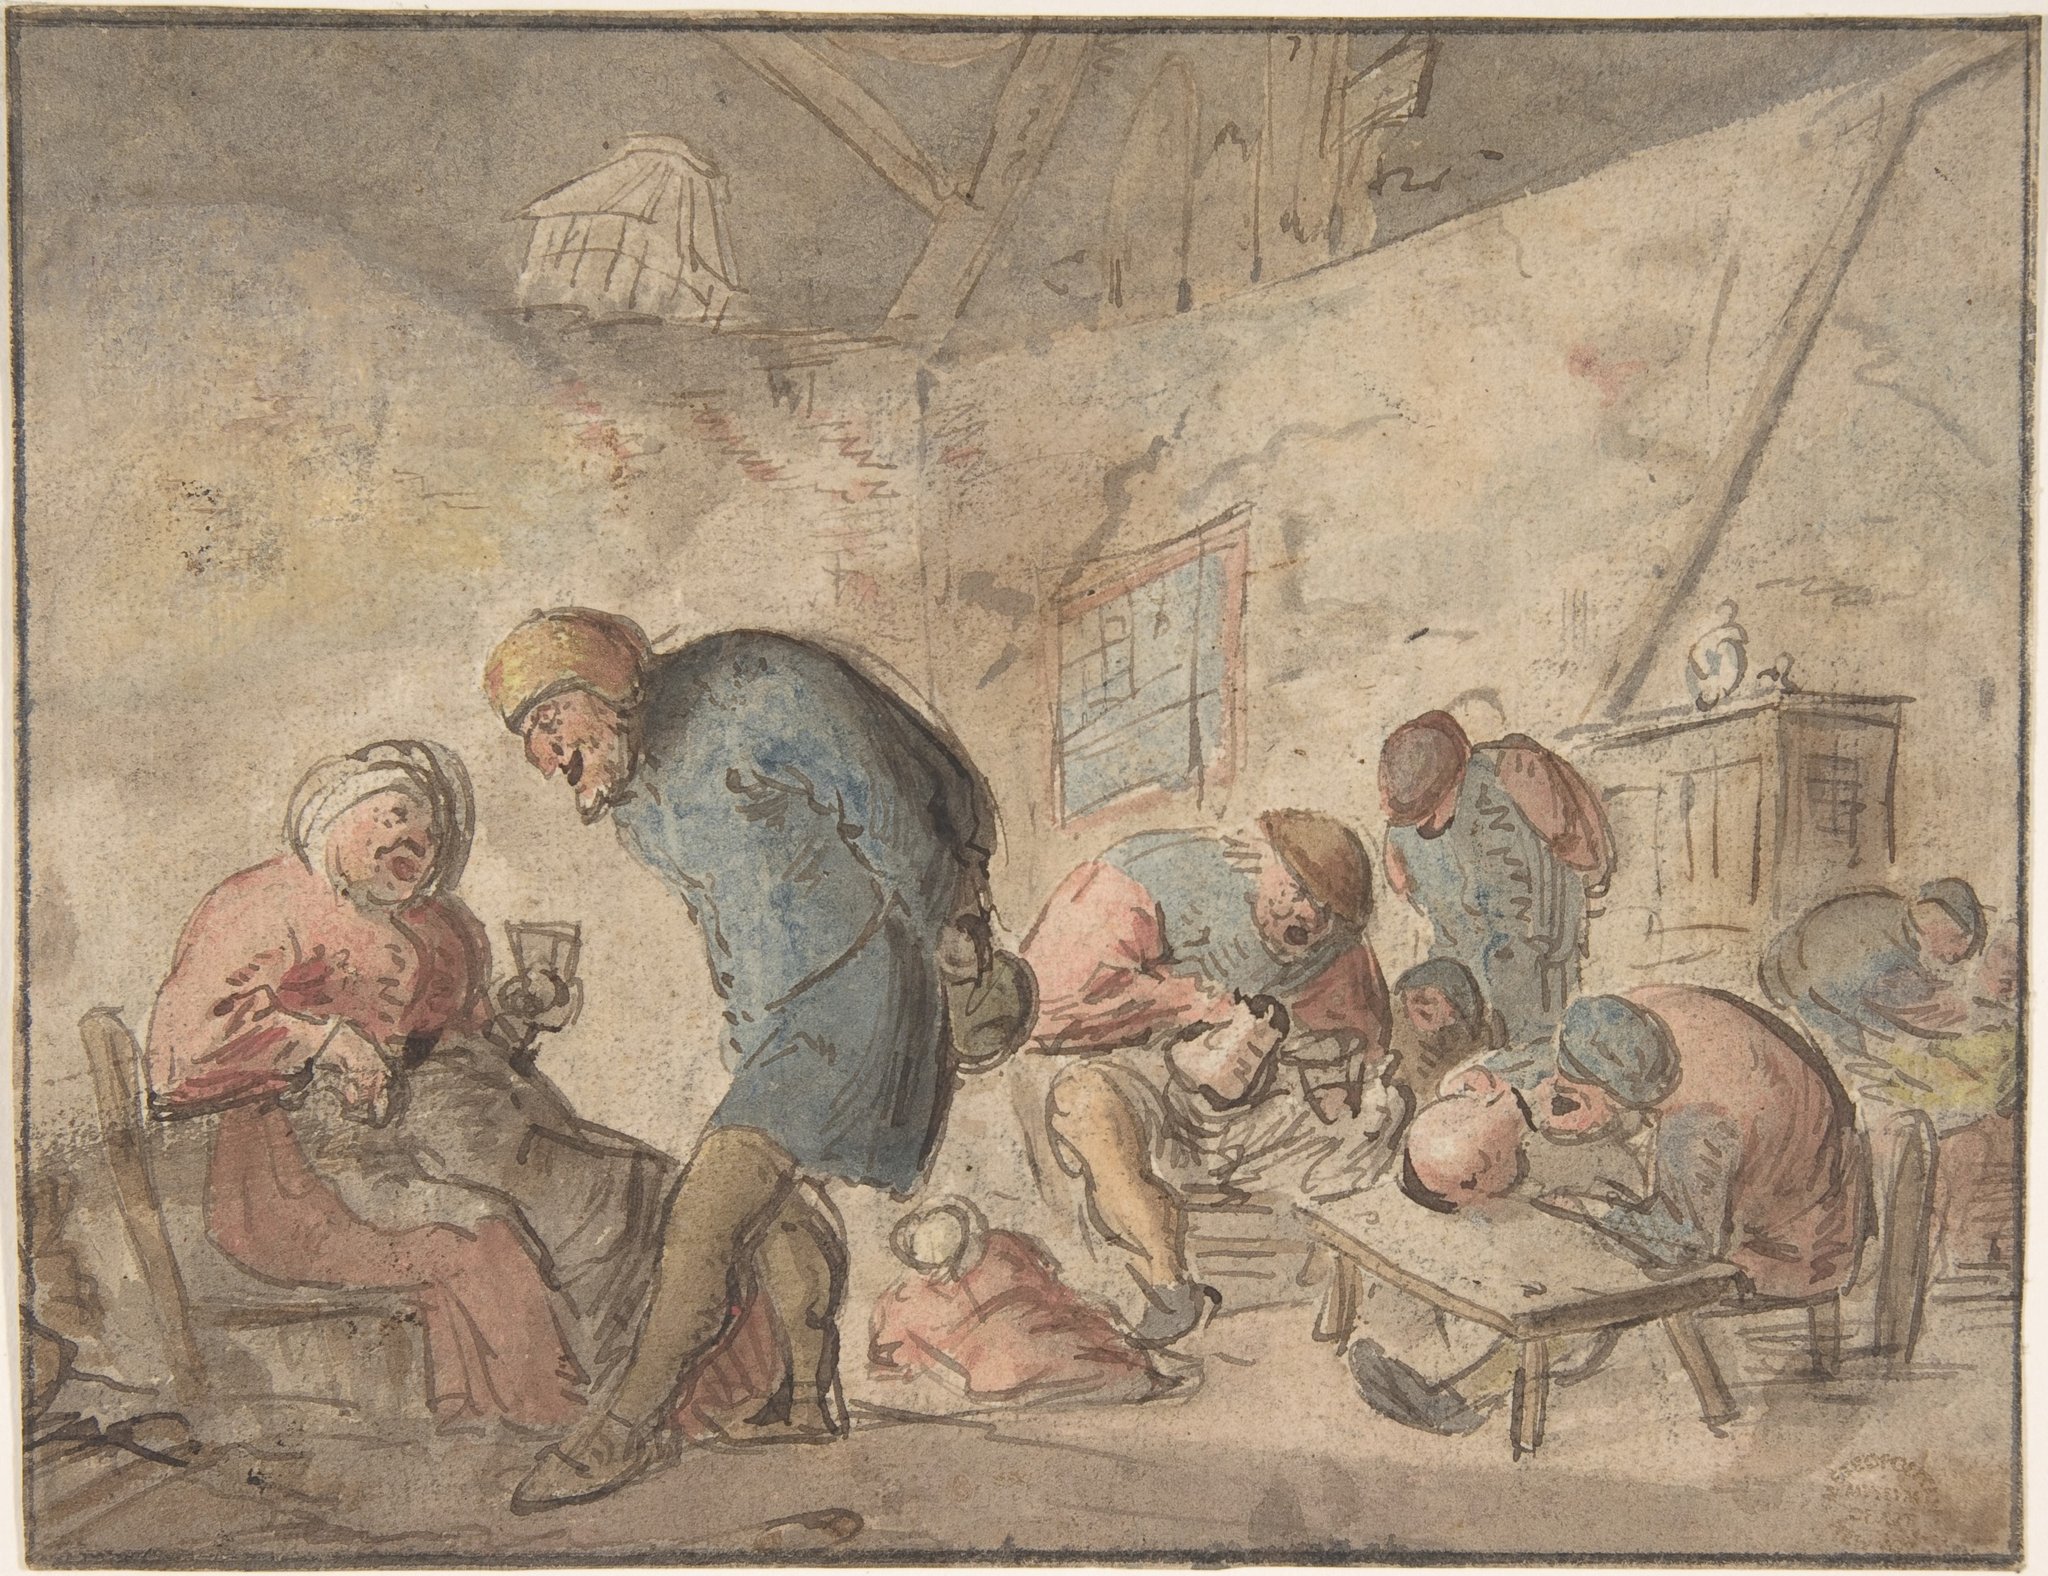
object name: drawing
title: Peasants Drinking, verso: sketches of peasants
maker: adriaen van ostade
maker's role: artist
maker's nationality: dutch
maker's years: 1610-1685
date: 1610-1685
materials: chalk, ink, watercolor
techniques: pen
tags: drunkenness,men,women,drinking